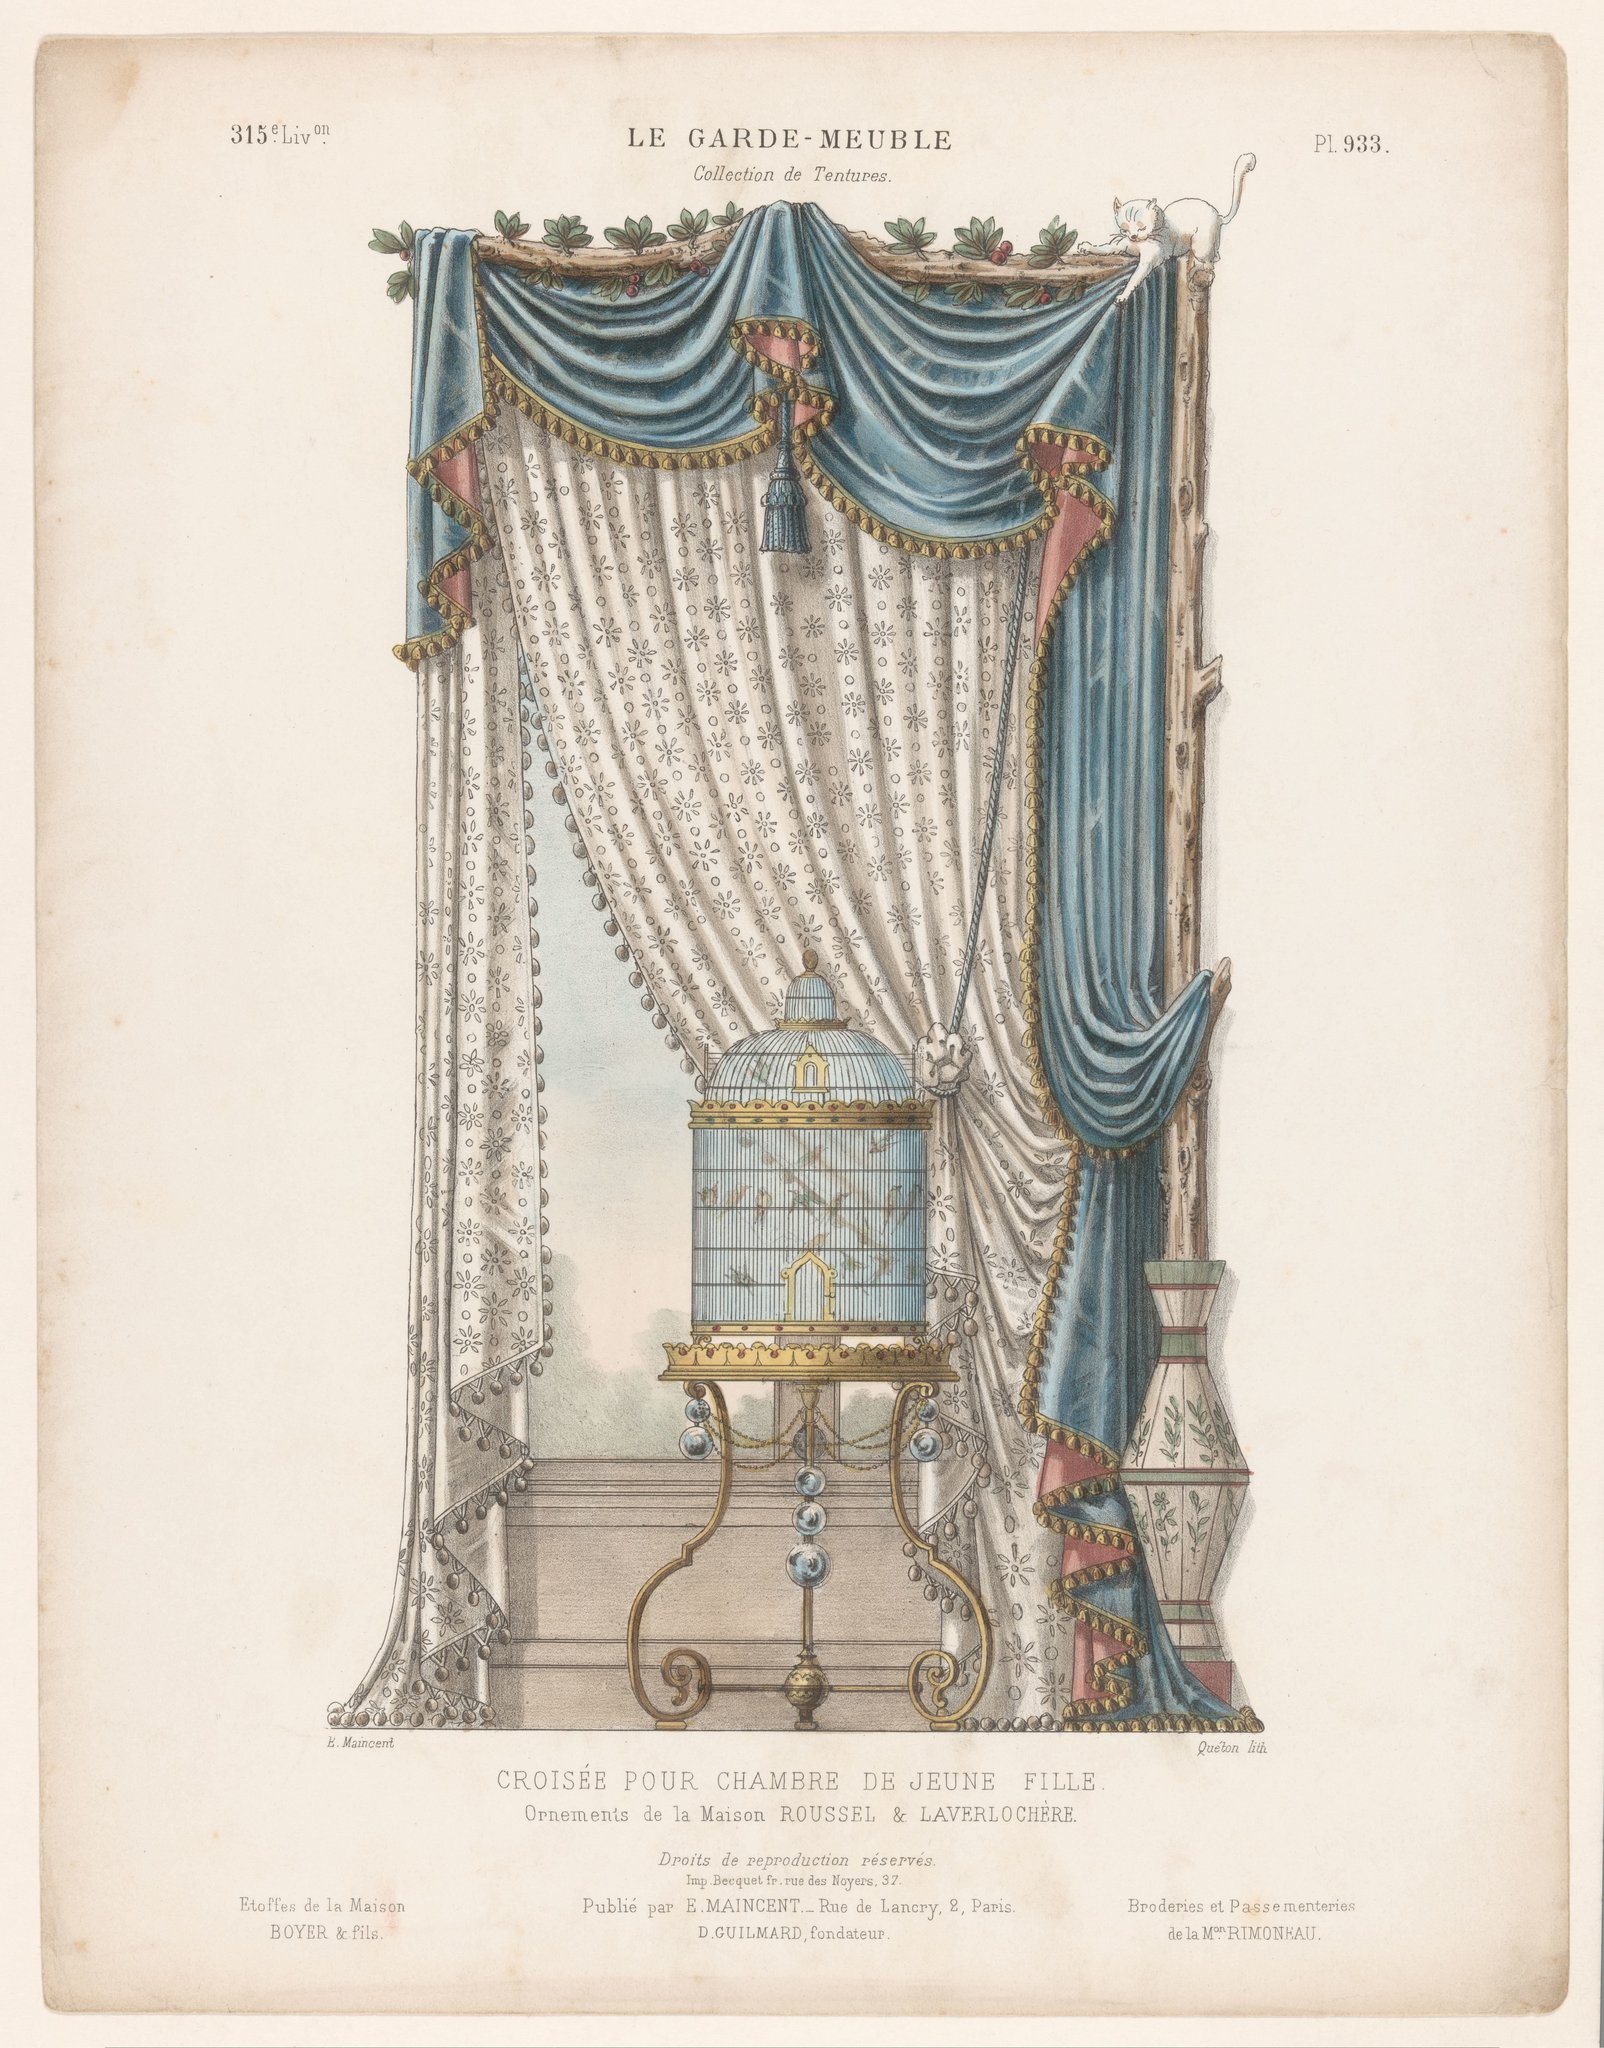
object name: print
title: Croisée pour Chambre de jeune Fille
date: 1885-1895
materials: paper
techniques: hand coloring, lithograph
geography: paris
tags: window, hangings and drapery, bird in a cage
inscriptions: : ‘Droits de reproduction réservés.’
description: Kruisvenster van een meisjeskamer met gedrapeerde gordijnen en een vogelkooi. Prent uit 315e Livraison.